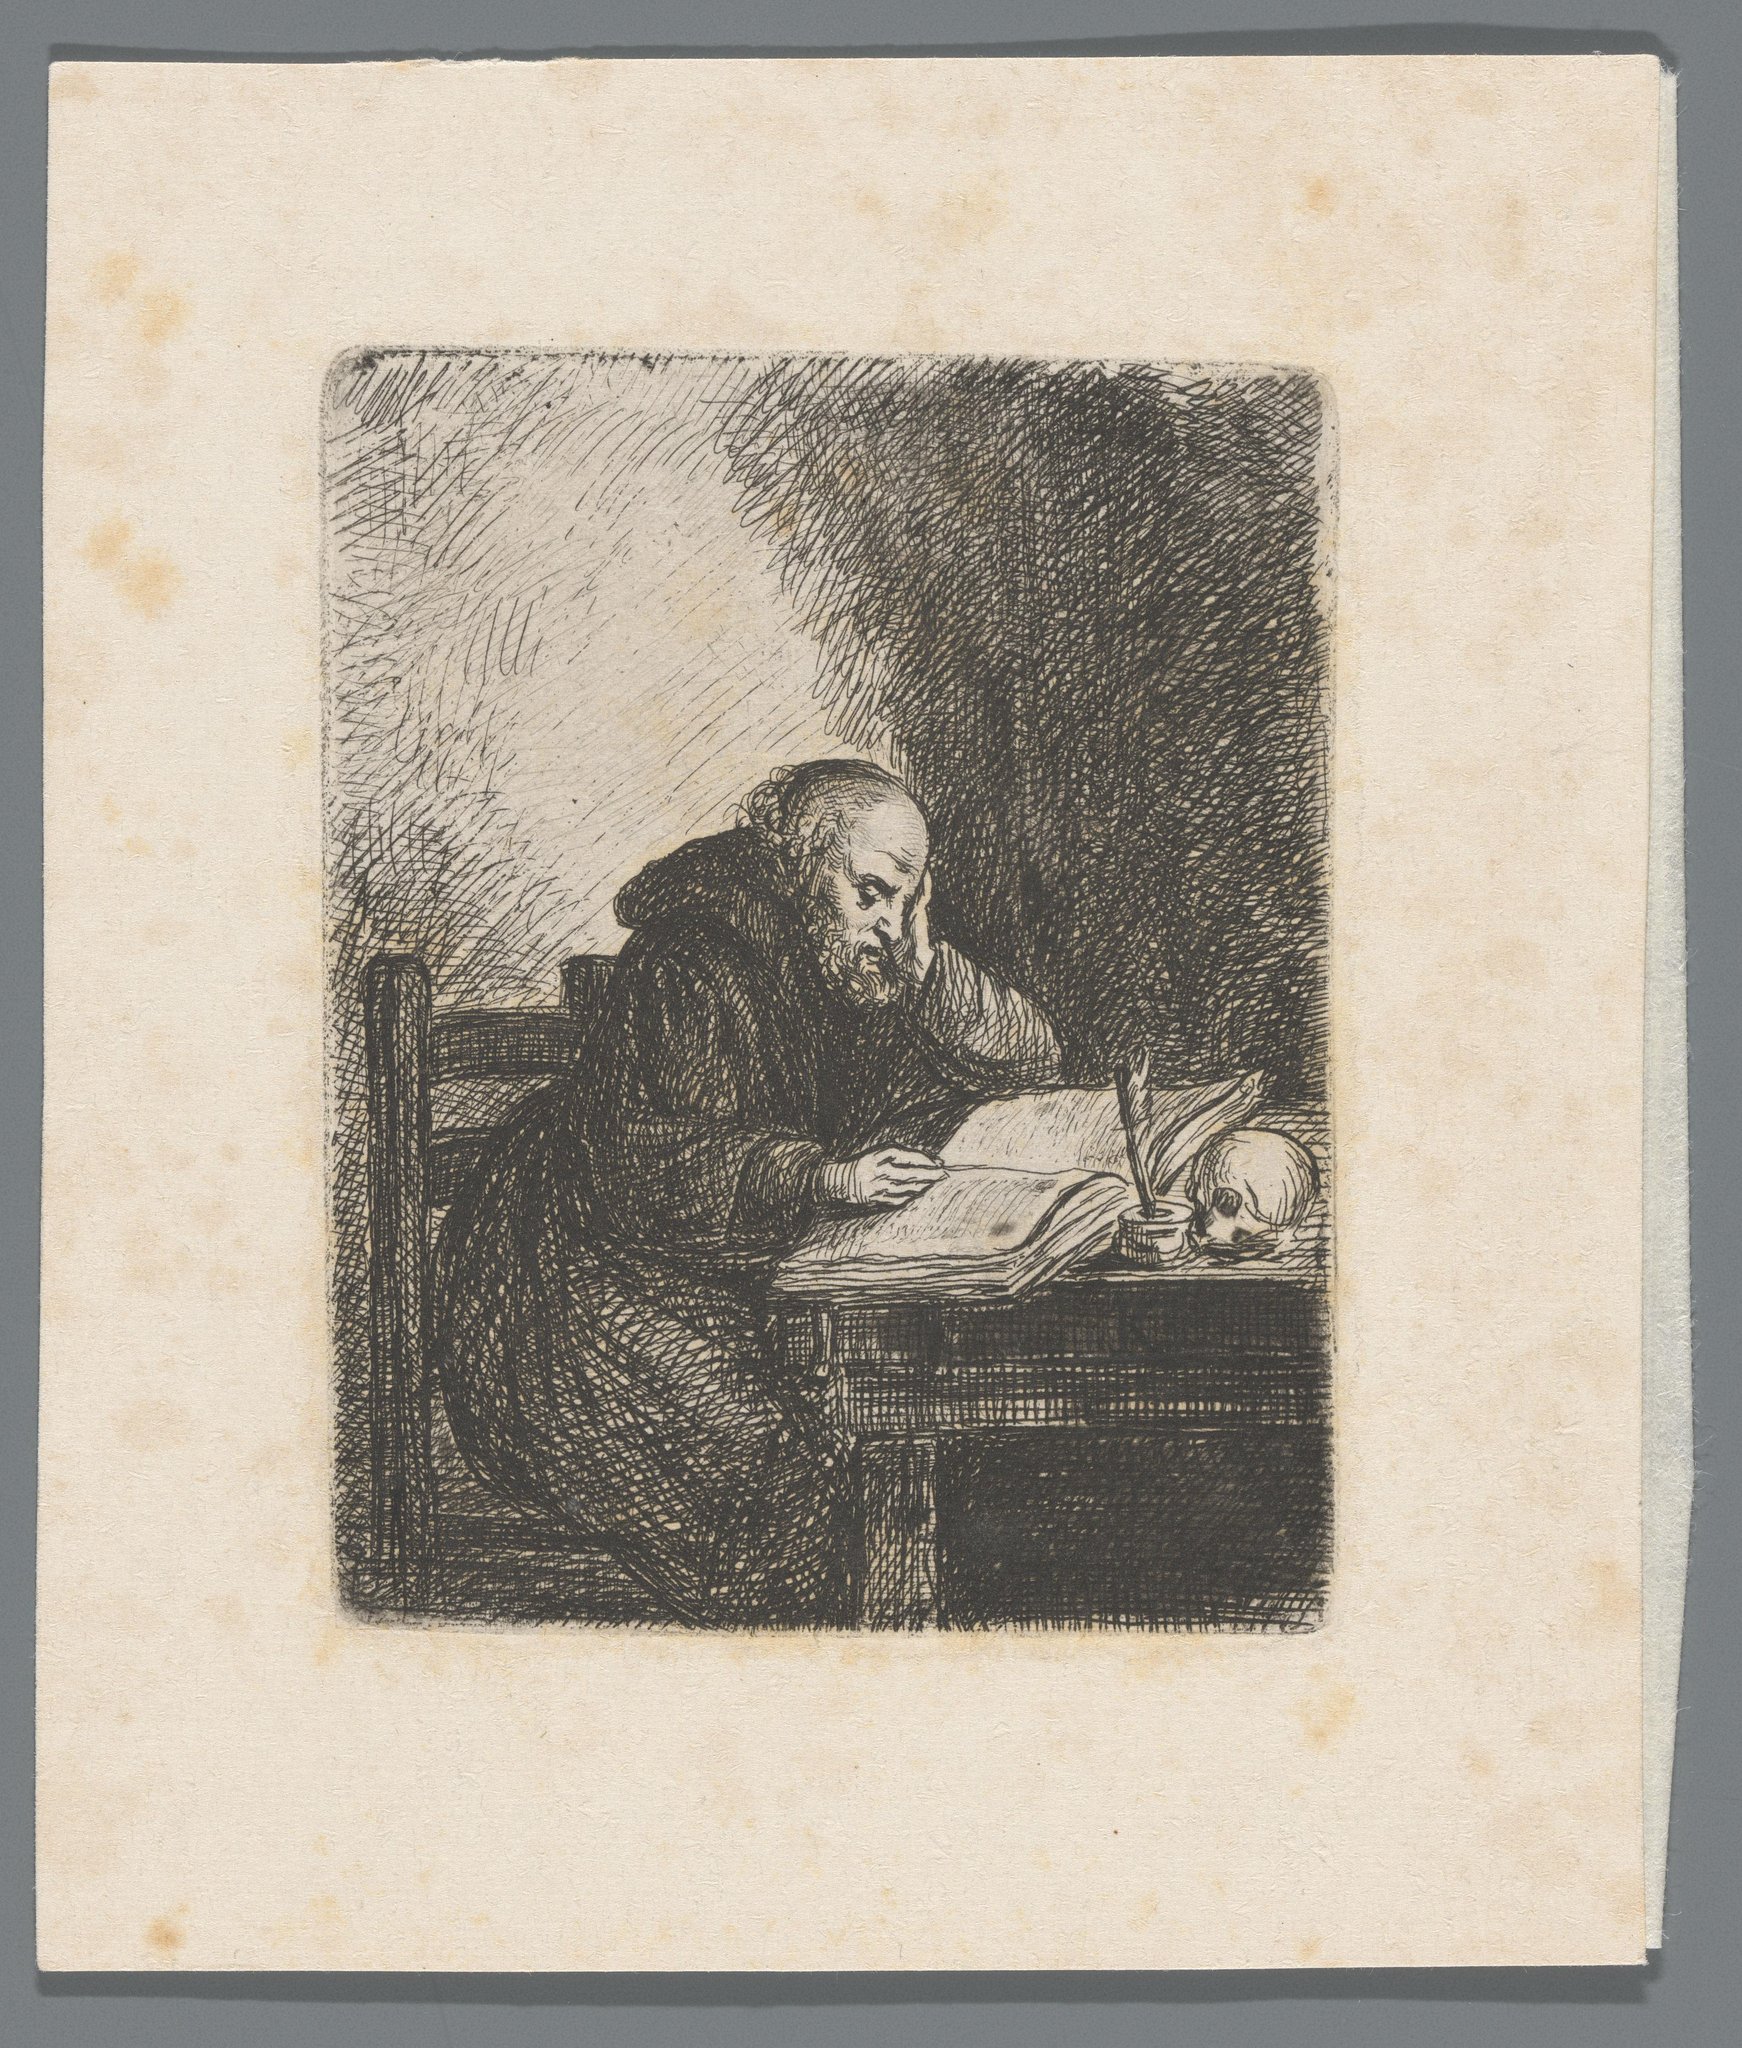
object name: print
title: Lezende monnik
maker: david van der kellen (1804-1879)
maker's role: die cutter, draughtsman, print maker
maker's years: 1804-1879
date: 1814-1859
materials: paper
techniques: drypoint, etching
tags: reading, (human) skull, monk(s), friar(s)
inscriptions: collector's mark: Lugt 2228, monogram: ‘vdK’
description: In een vertrek zit een monnik aan tafel een boek te lezen. Op de tafel staan een schedel en een inktpot met daarin een schrijfveer.